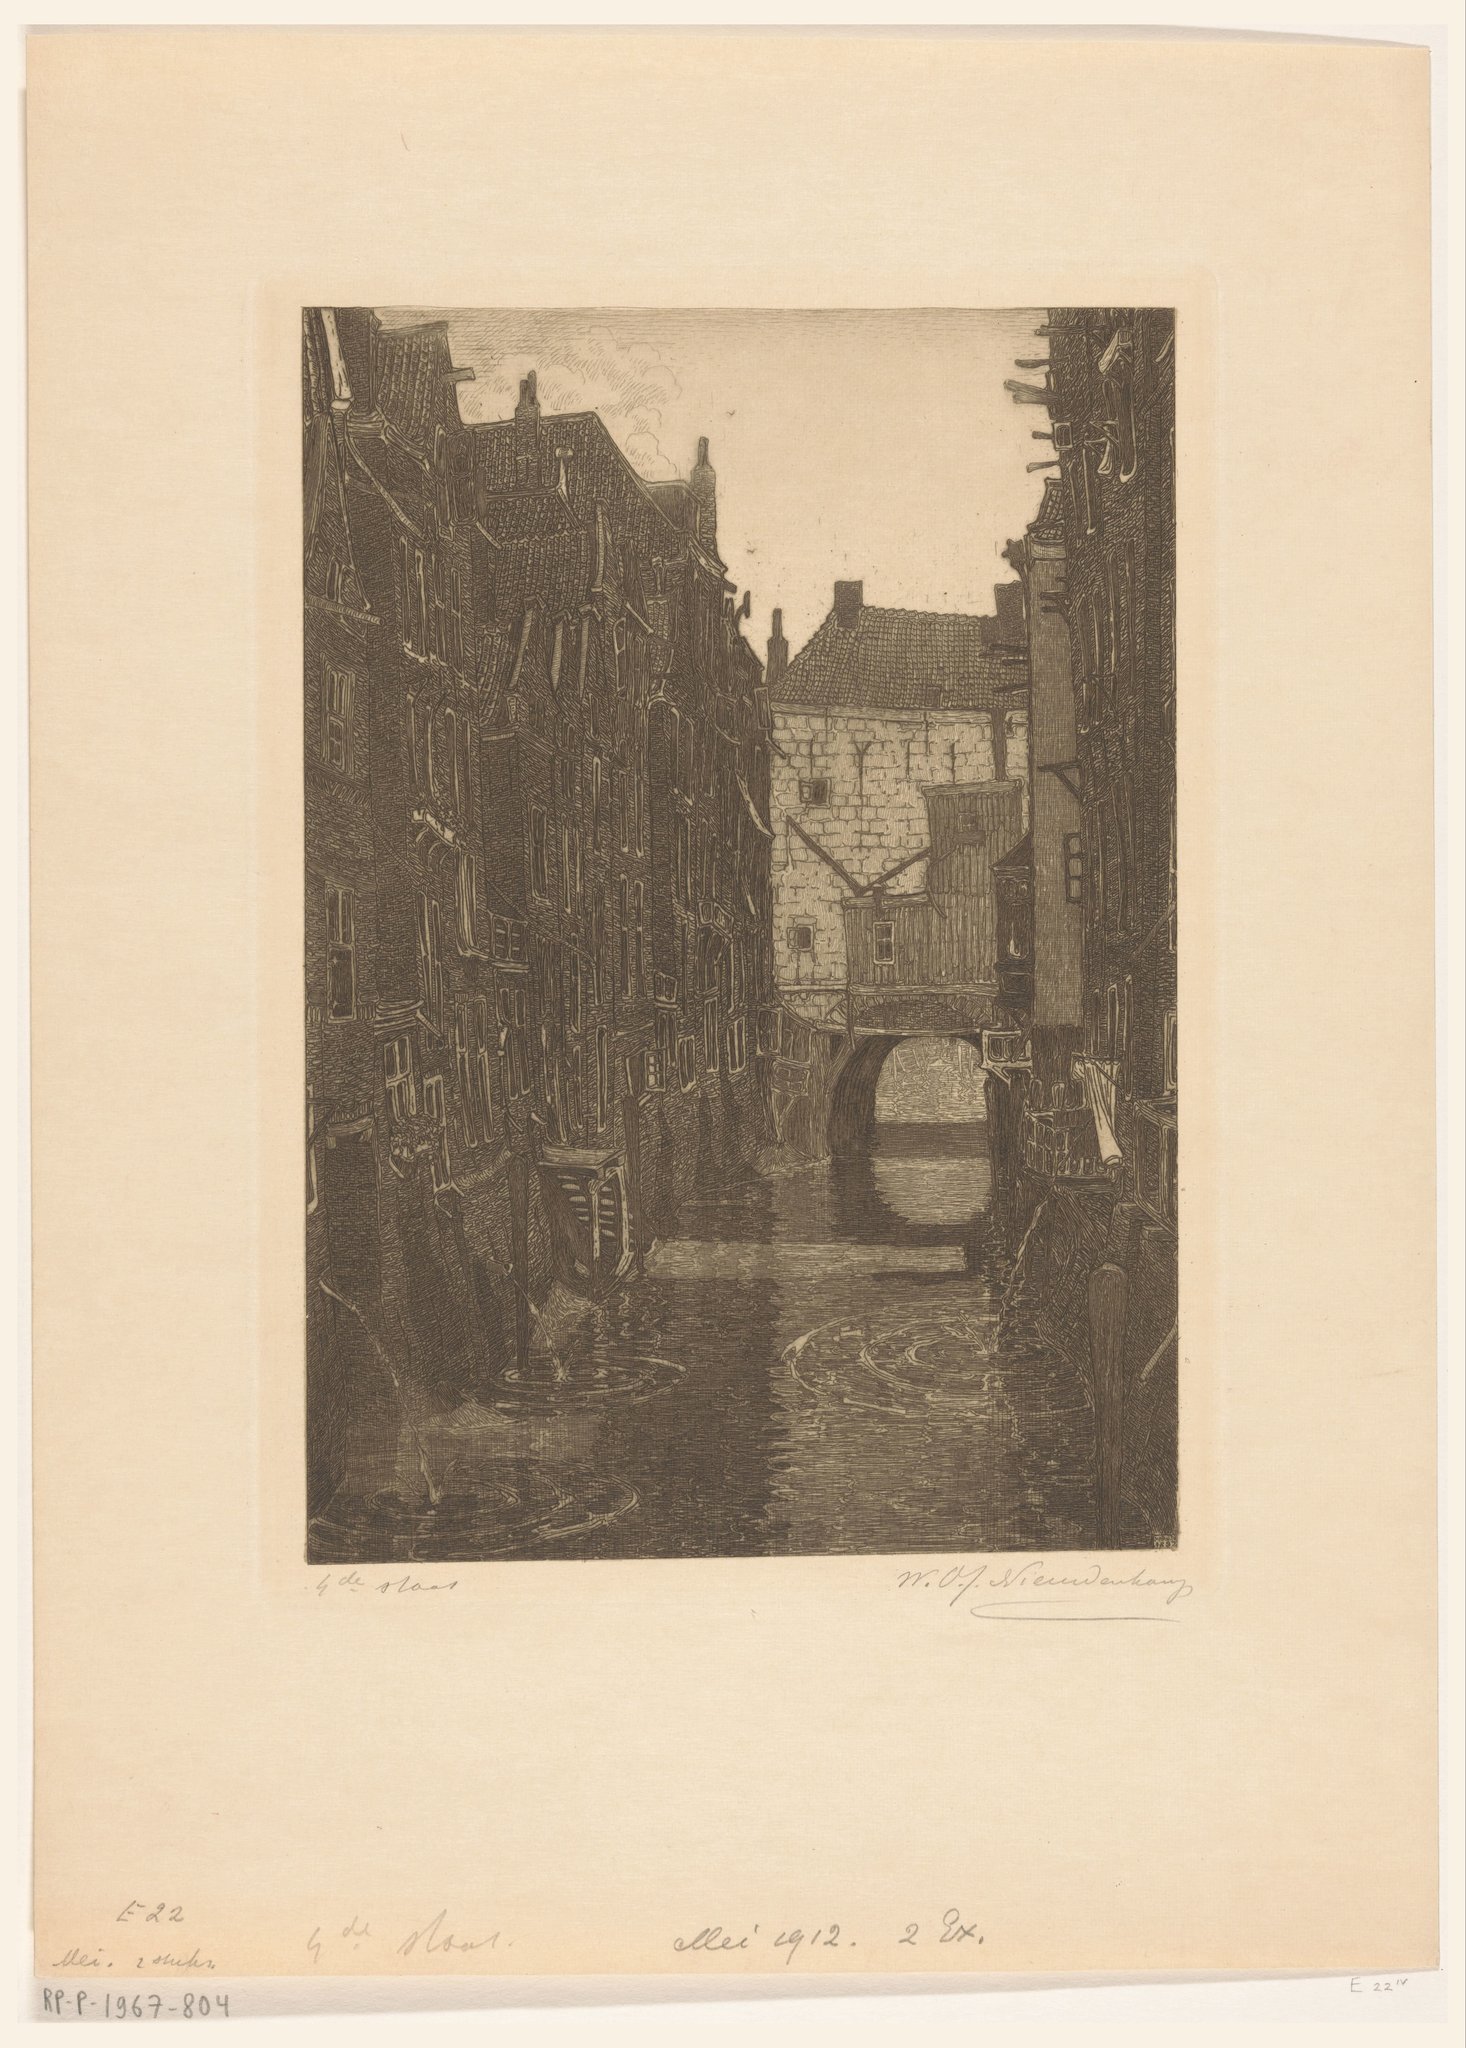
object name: print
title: Huizen aan de Voorstraatshaven in Dordrecht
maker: wijnand otto jan nieuwenkamp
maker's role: draughtsman, print maker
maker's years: 1874-1950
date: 1897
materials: paper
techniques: etching, intaglio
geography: amsterdam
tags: canals, waters (in city)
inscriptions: collector's mark: Lugt 2228, collector's mark: Lugt 2760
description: Op de achtergrond de achtergevel van het stadhuis van Dordrecht.